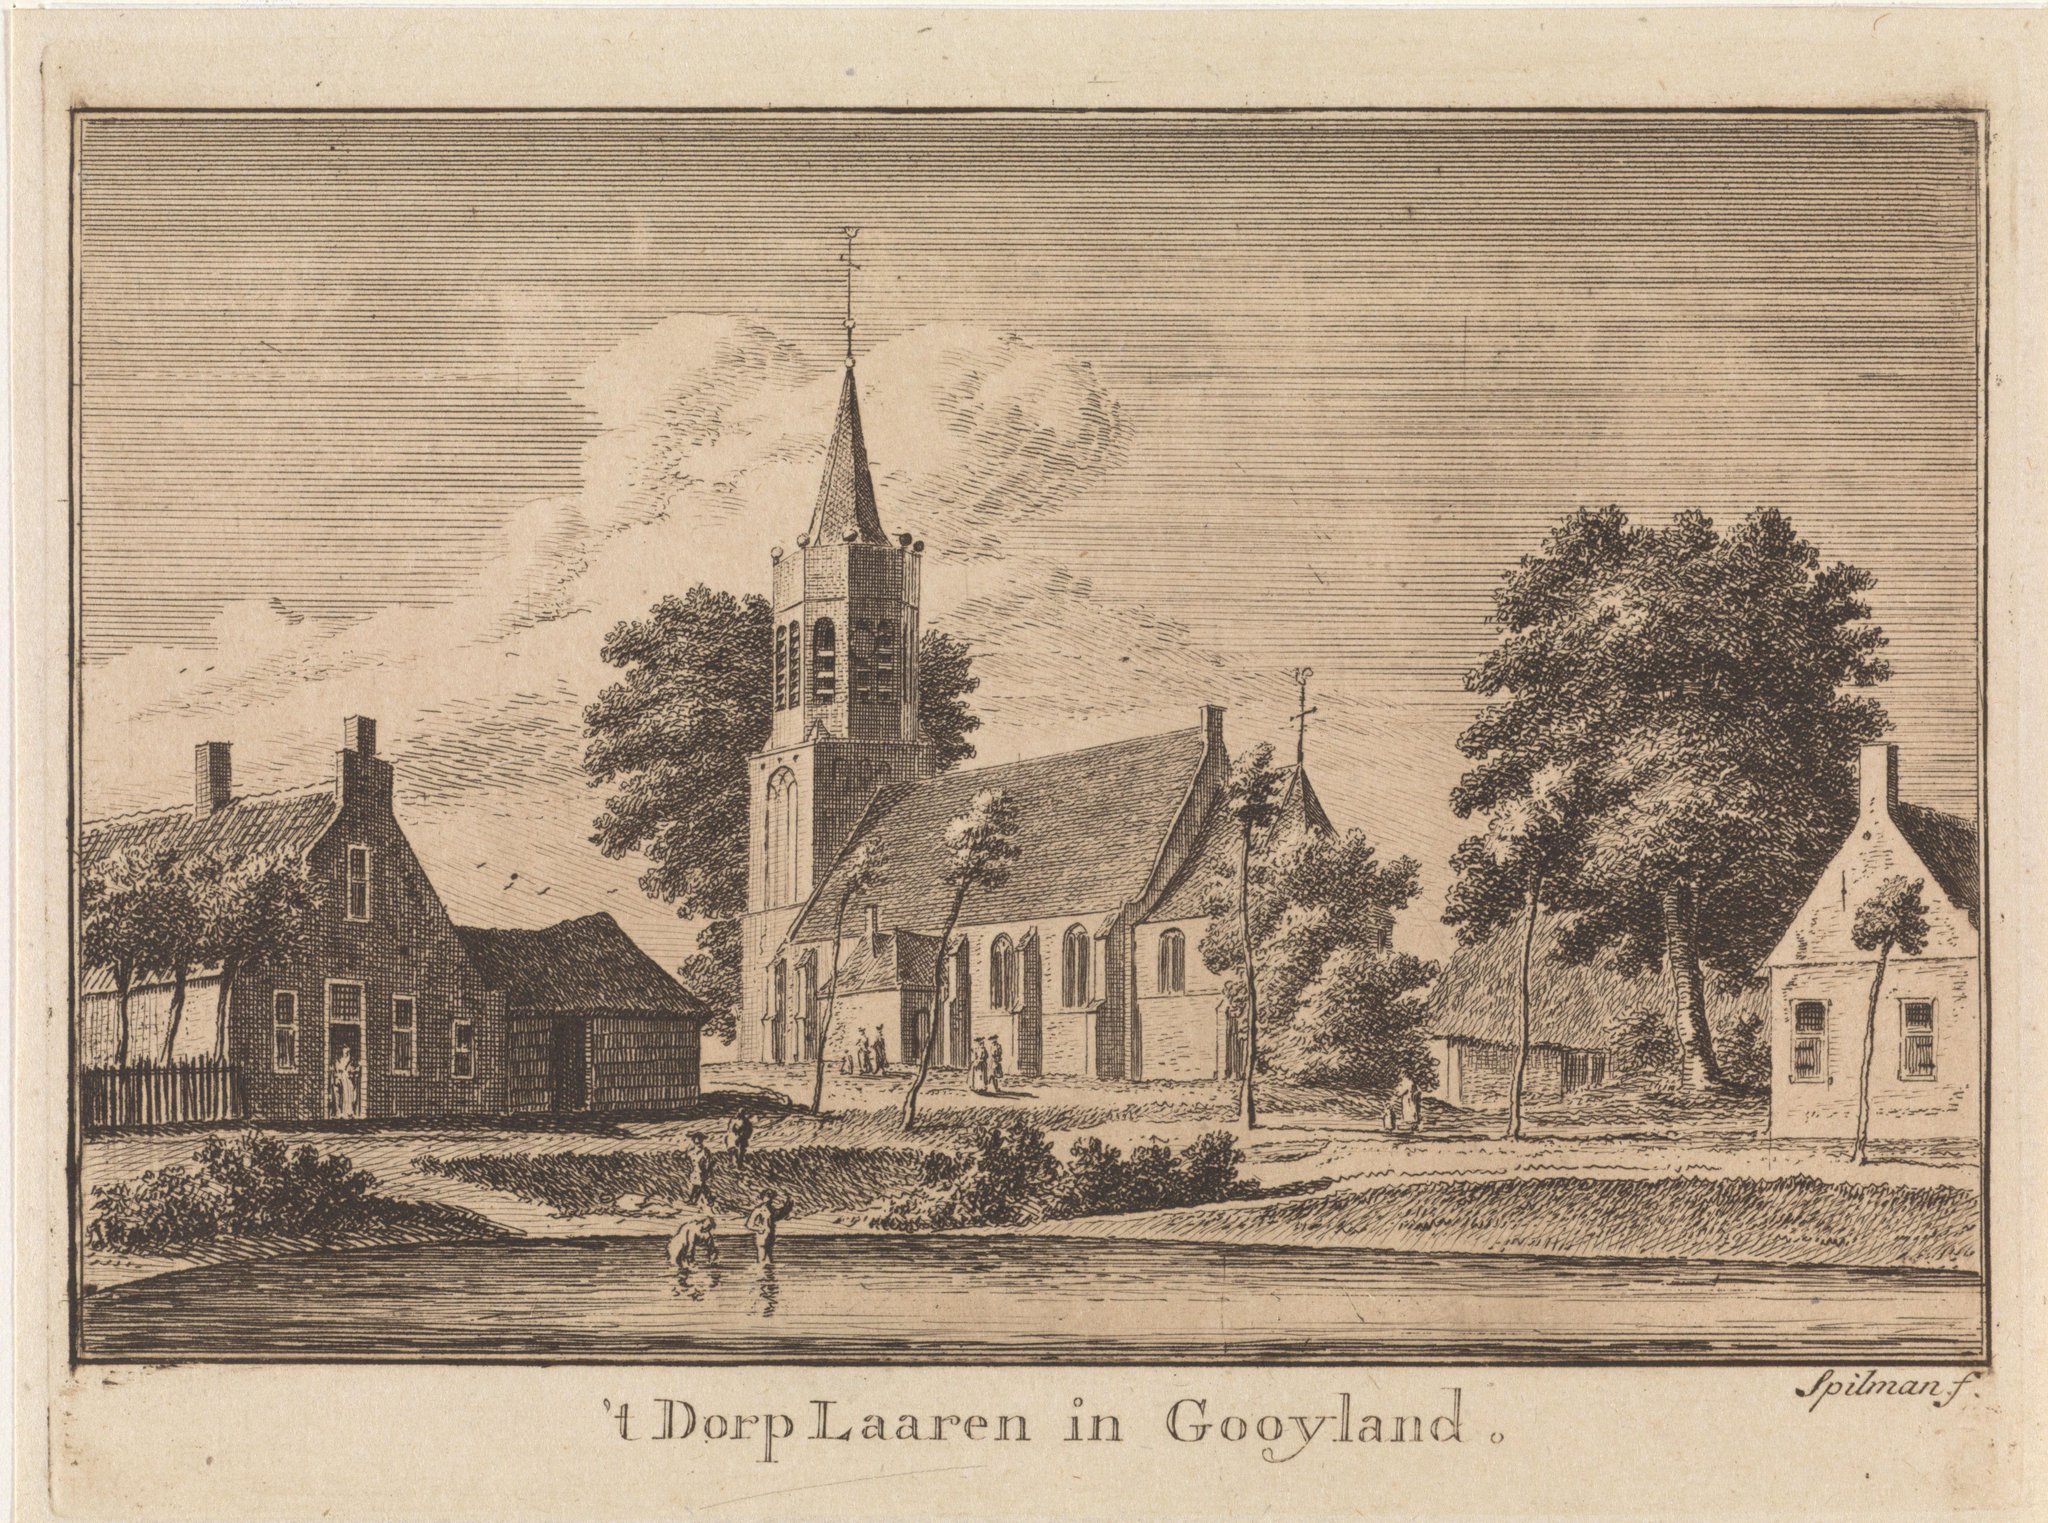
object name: print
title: Gezicht op Laren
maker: hendrik spilman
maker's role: draughtsman, painter, print maker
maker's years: 1721-1784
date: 1742-1784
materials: paper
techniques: etching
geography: haarlem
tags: church (exterior), public road in village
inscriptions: collector's mark: Lugt 2228